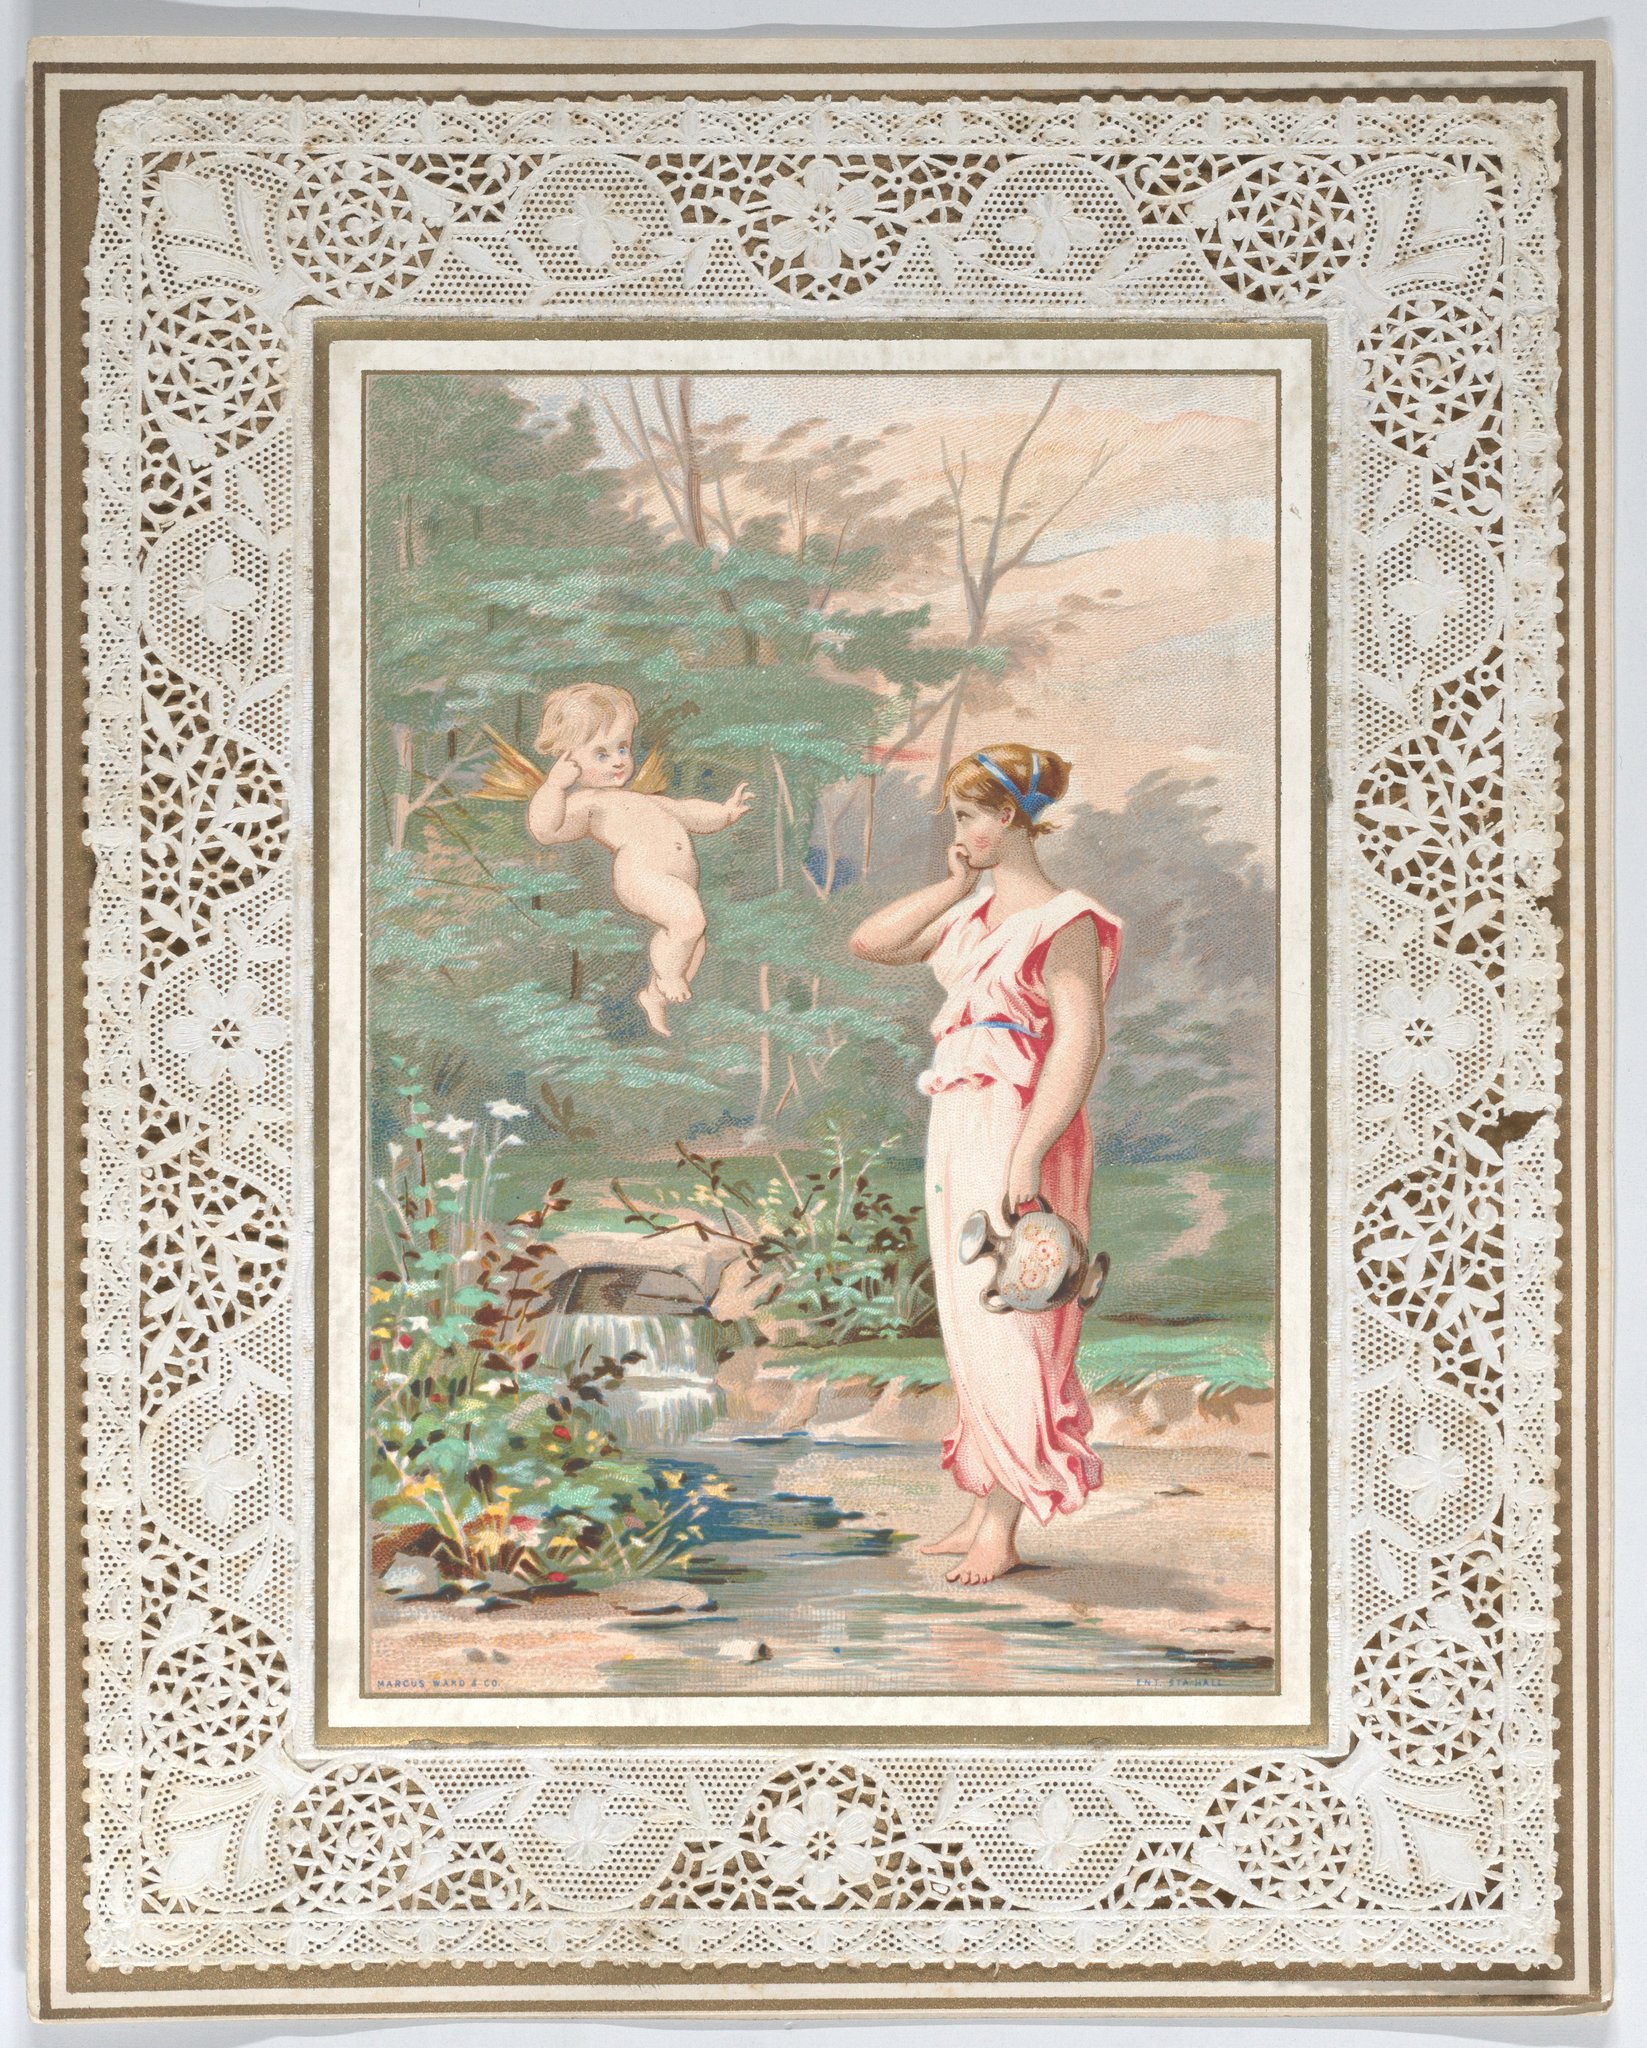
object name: valentine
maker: Anonymous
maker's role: artist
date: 1880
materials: gold, lace, paper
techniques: chromolithography, lithograph